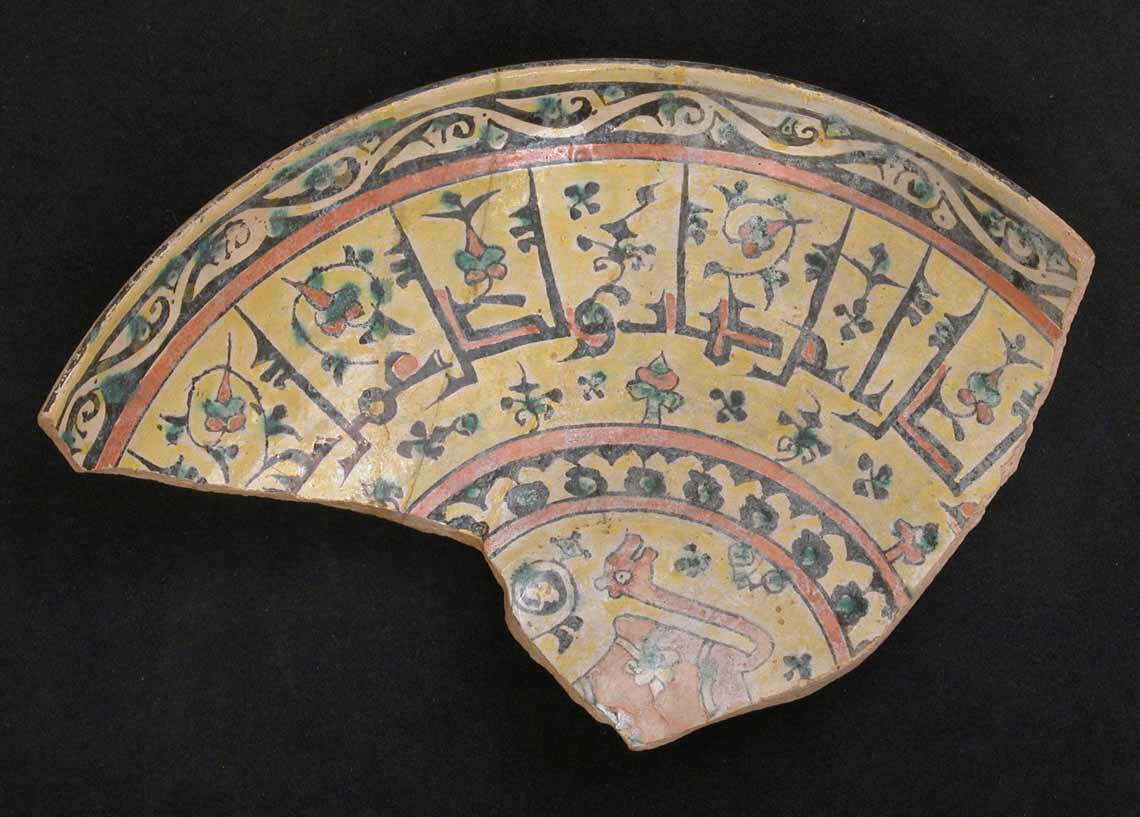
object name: fragment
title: Fragments of a Bowl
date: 901-1000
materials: earthenware, glaze, pigment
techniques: painting, polychrome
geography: iran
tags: animals